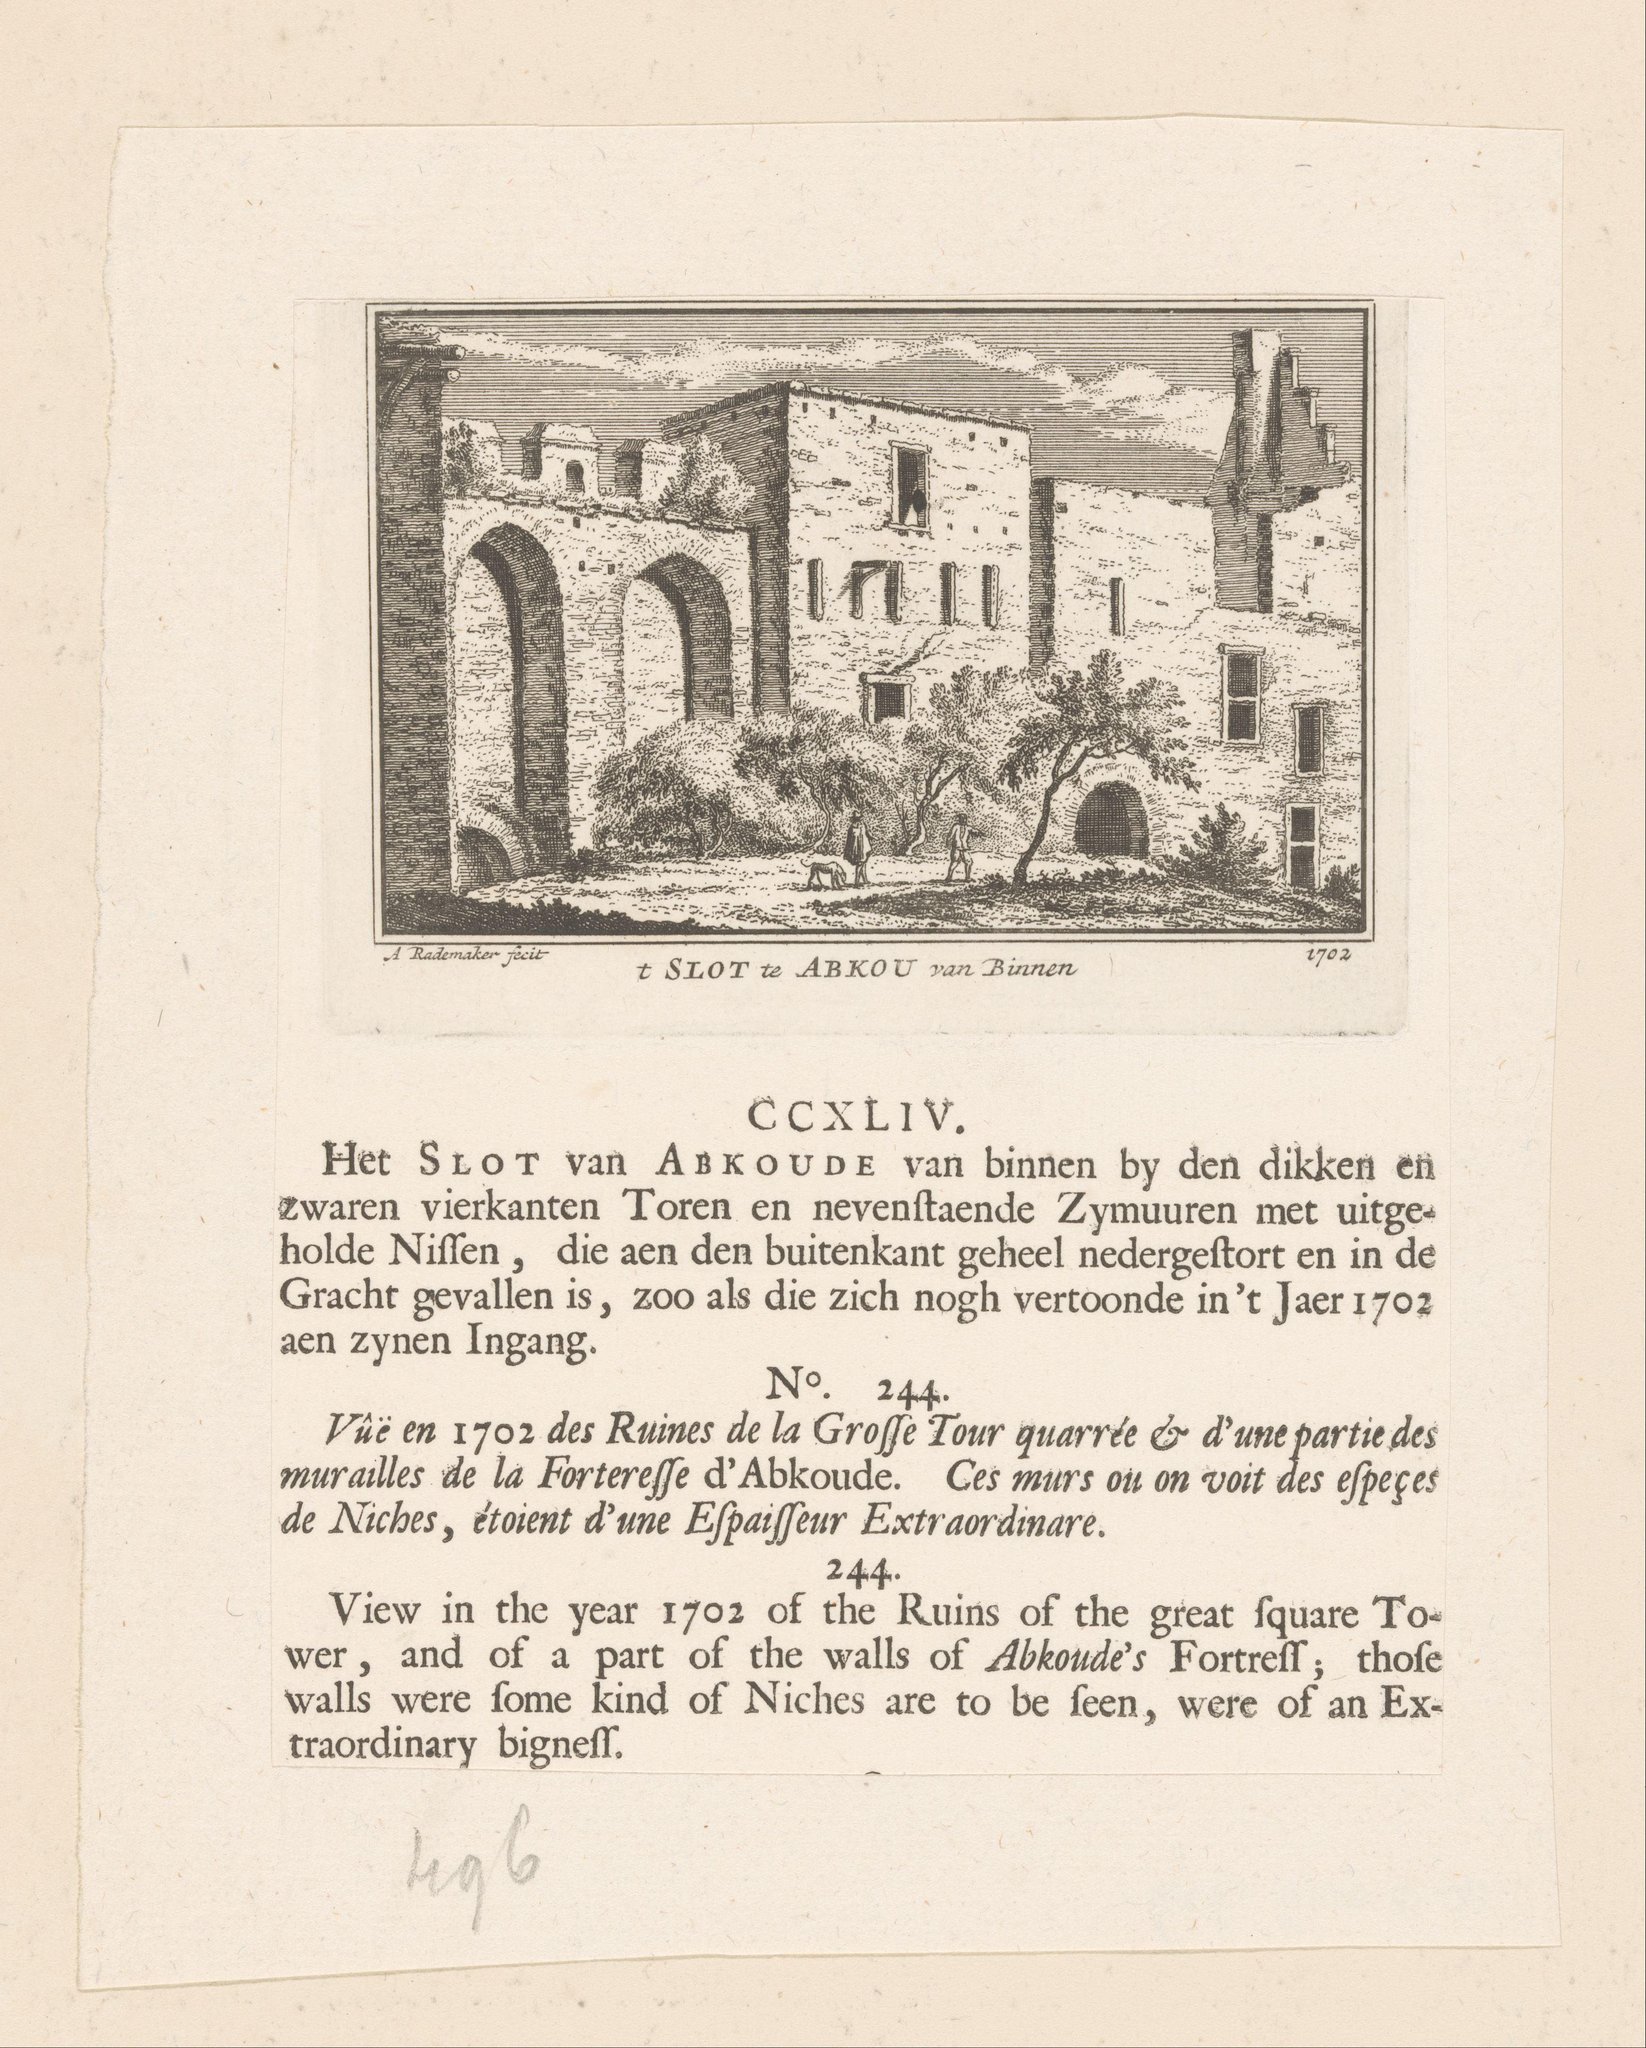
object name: book illustration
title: t Slot te Abkou van binnen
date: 1725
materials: paper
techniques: engraving, etching, letterpress printing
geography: amsterdam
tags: castle, landscape with tower or castle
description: Prent uit: Rademaker, Abraham. Nederlandsche outheden en gezichten (...). Amsterdam: Willem Barents, 1725.